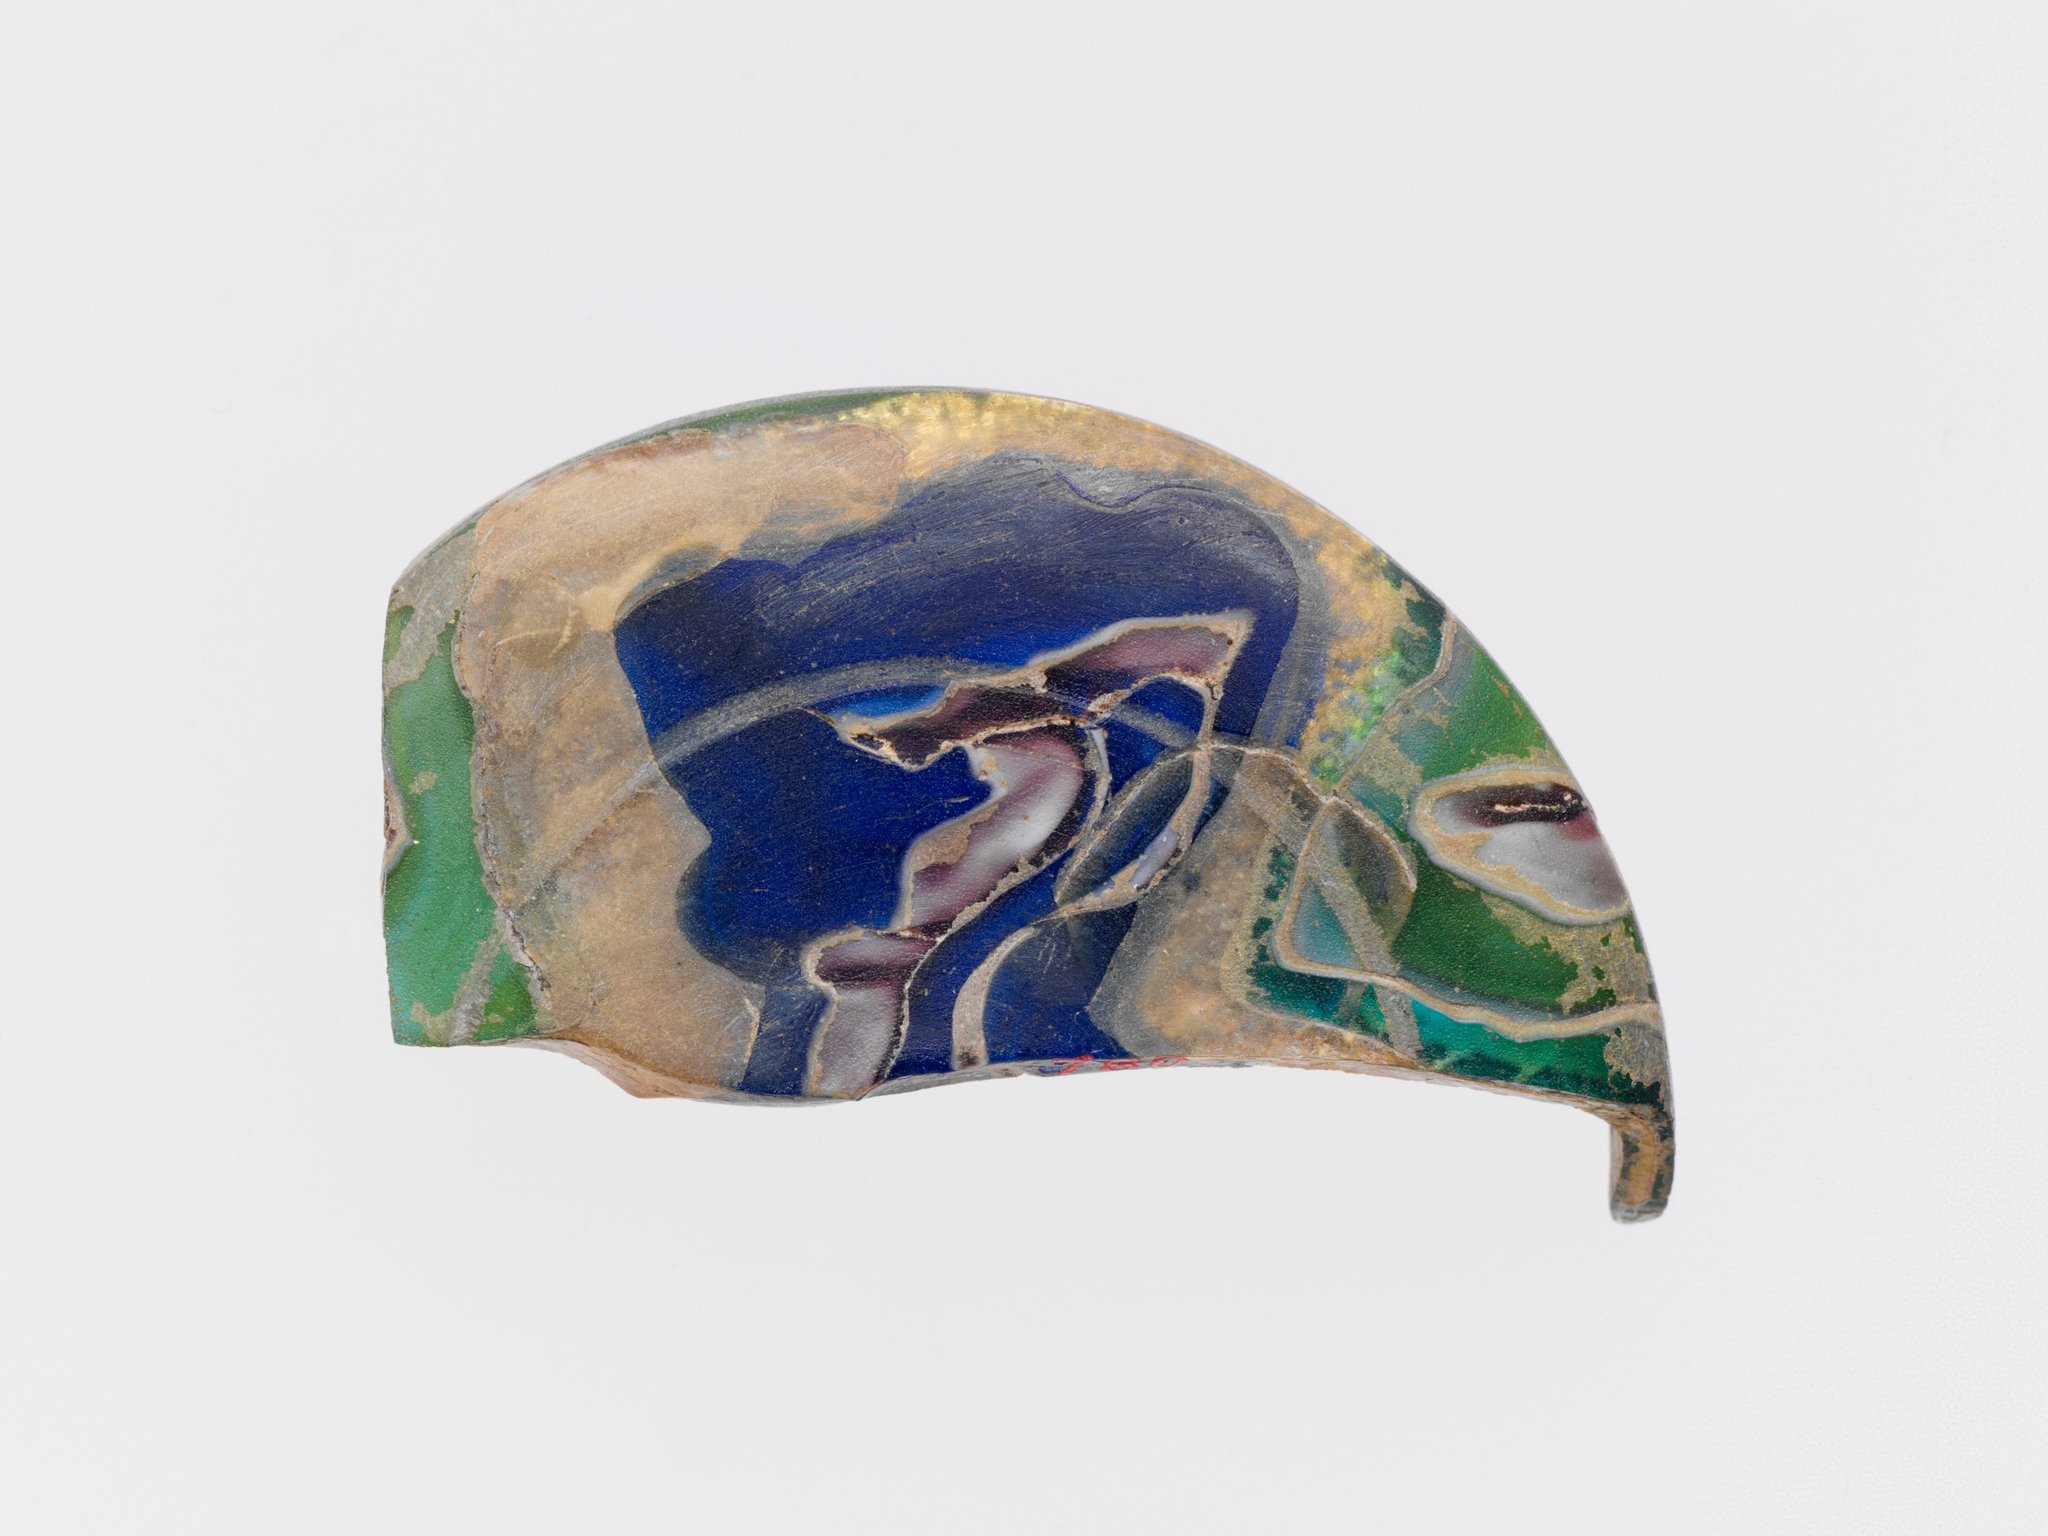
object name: lid fragment, gold band mosaic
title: Glass gold-band mosaic lid fragment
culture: roman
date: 1-50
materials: glass